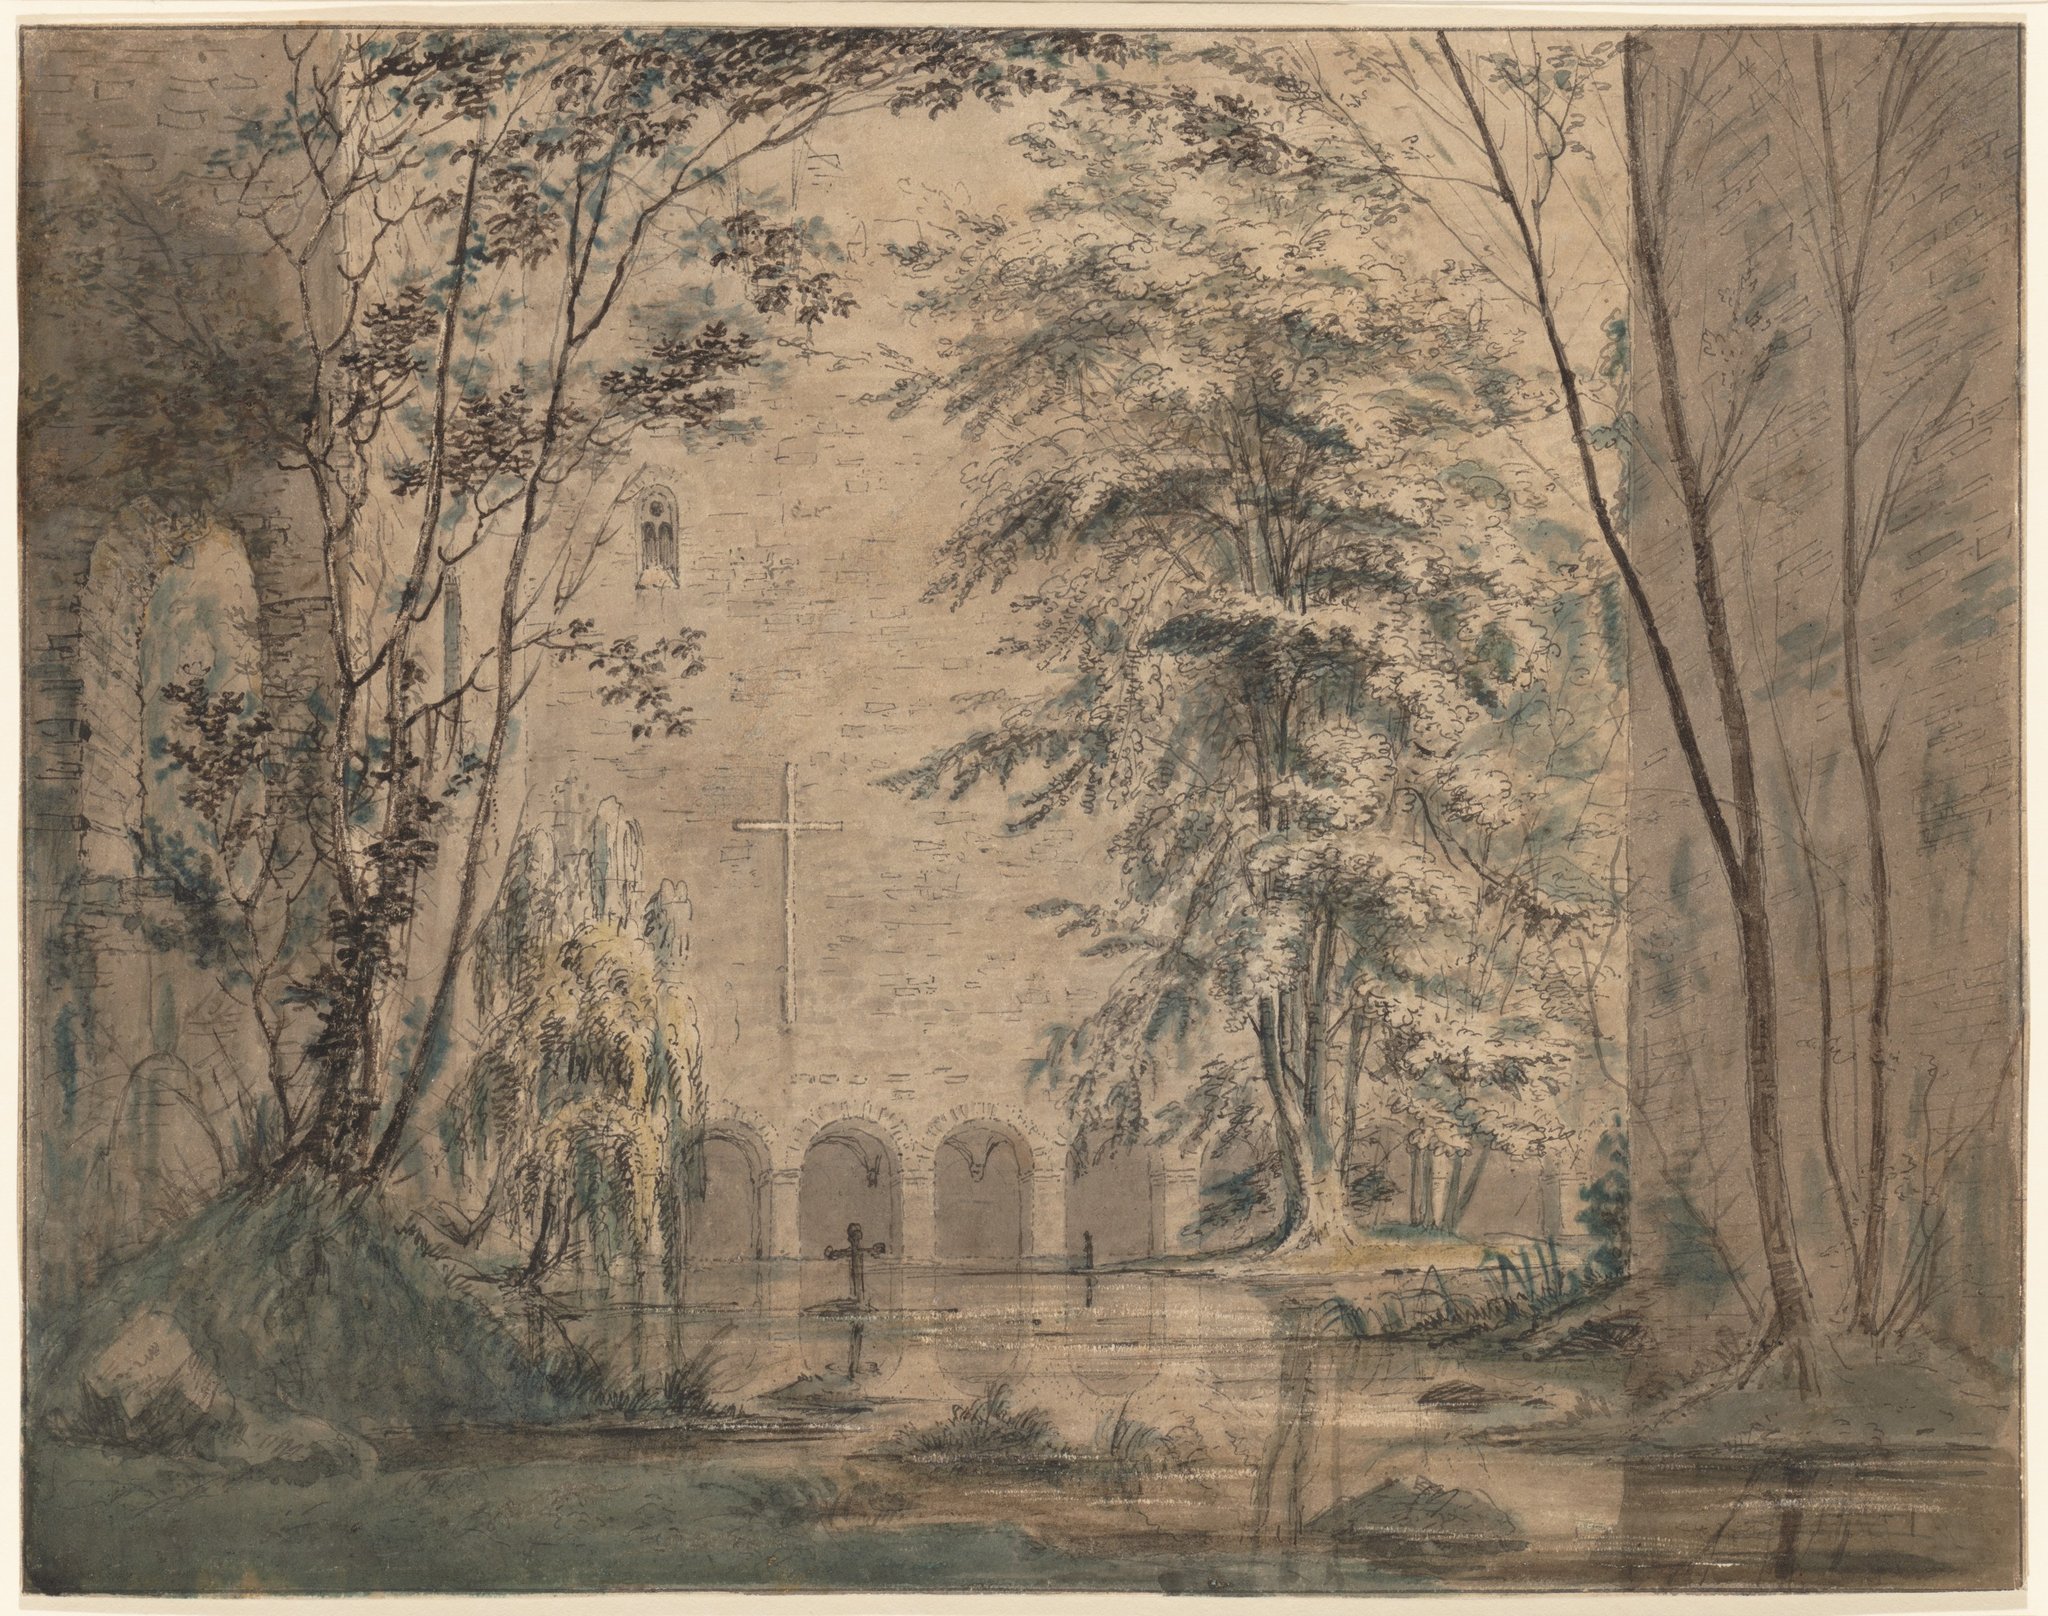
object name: drawing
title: Inundated Ruins of a Monastery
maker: karl blechen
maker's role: artist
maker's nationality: german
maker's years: 1798-1840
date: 1824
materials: ink, watercolor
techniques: pen, wash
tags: buildings,ruins,cross